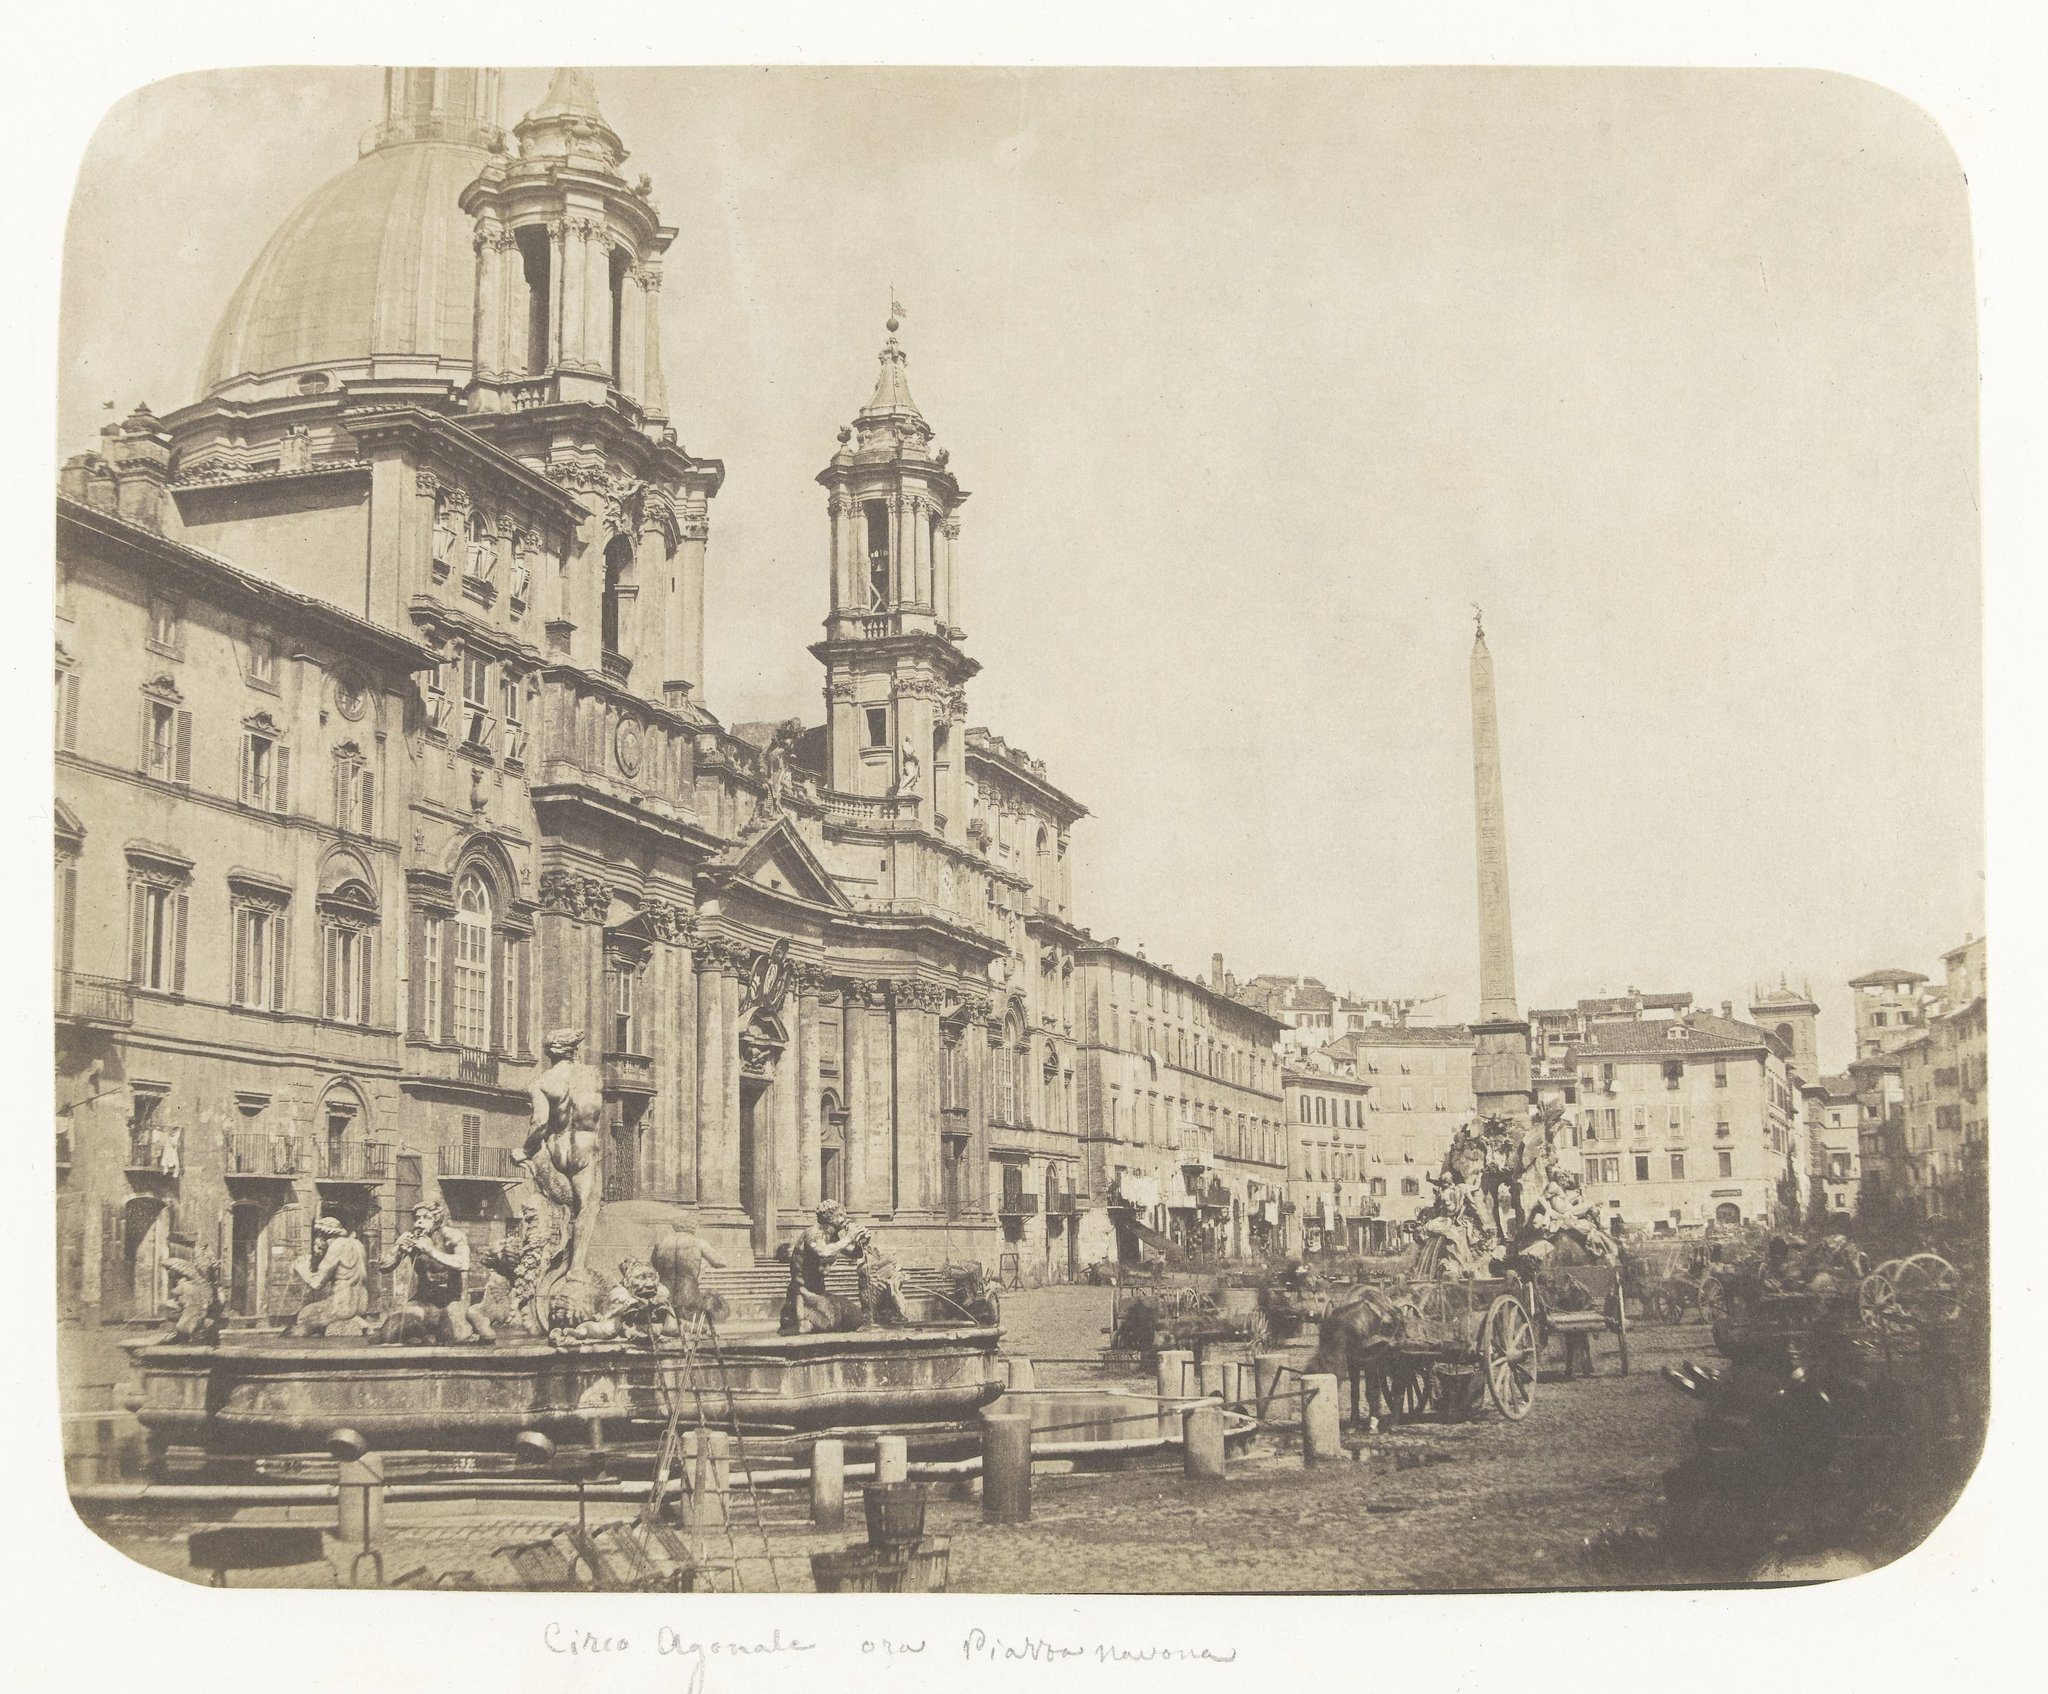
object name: photograph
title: Circo Agonale ora Piazza Navona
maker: giacomo caneva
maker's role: fotograaf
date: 1850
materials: paper, photographic support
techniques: salted paper print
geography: rome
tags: square, place, circus, etc., obelisk, needle, church (exterior), ornamental fountain